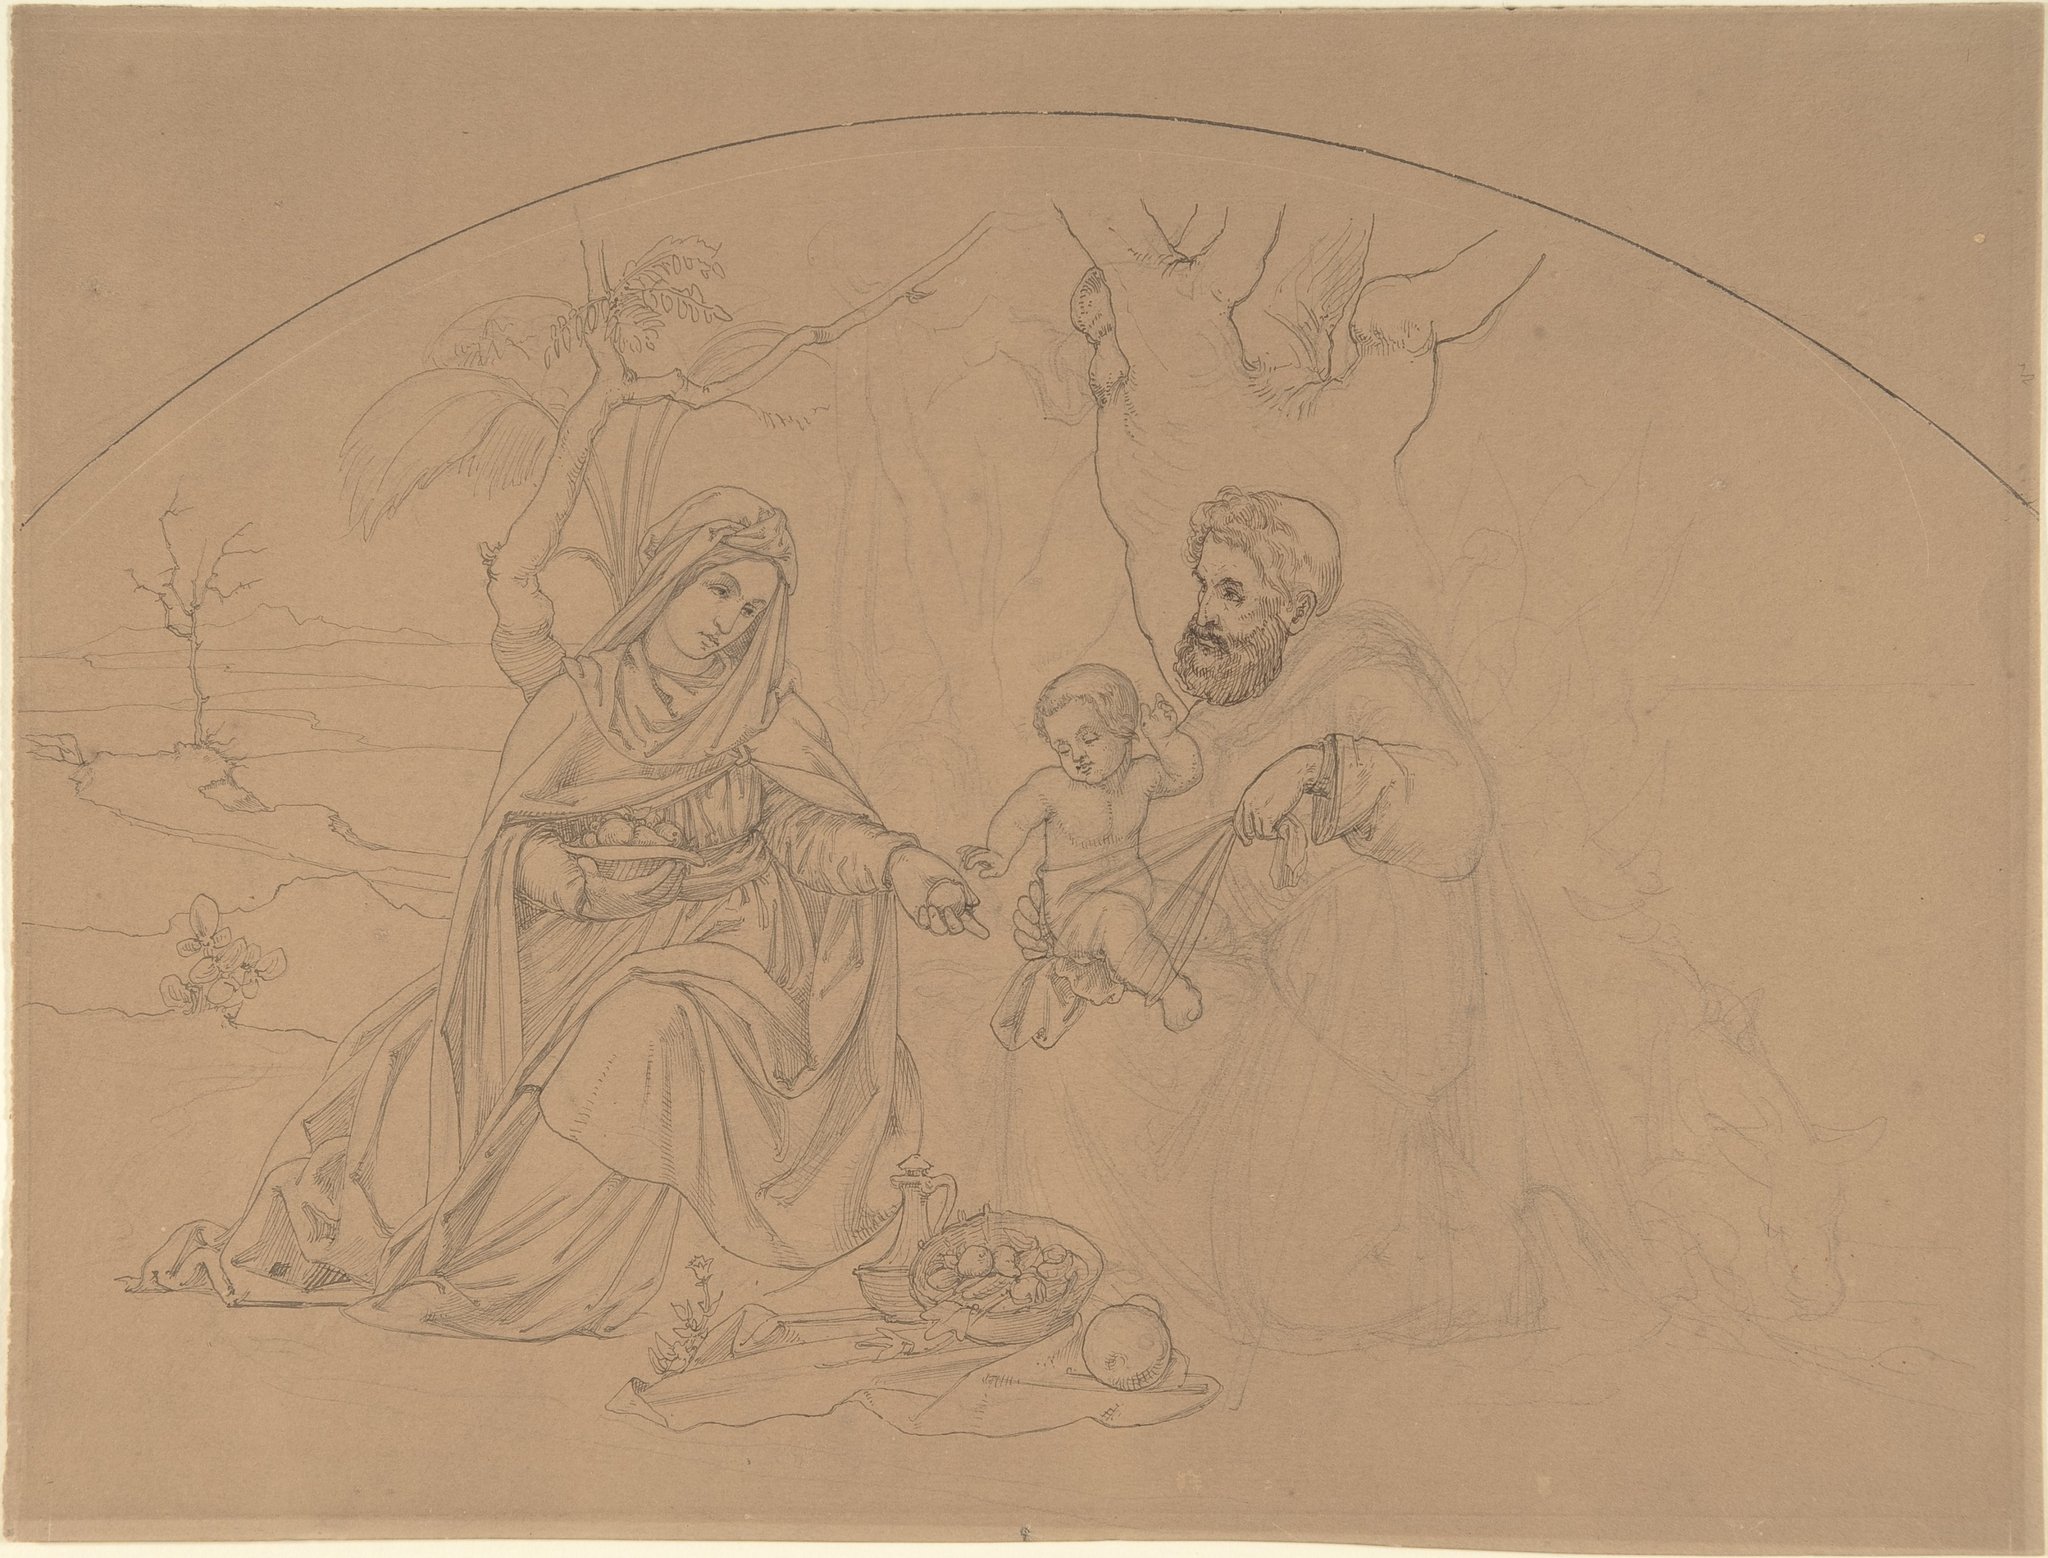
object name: drawing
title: Rest During the Flight into Egypt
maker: philipp veit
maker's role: artist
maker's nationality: german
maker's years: 1793-1877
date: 1800-1877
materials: pencil, paper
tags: christ,holy family,saint joseph,virgin mary